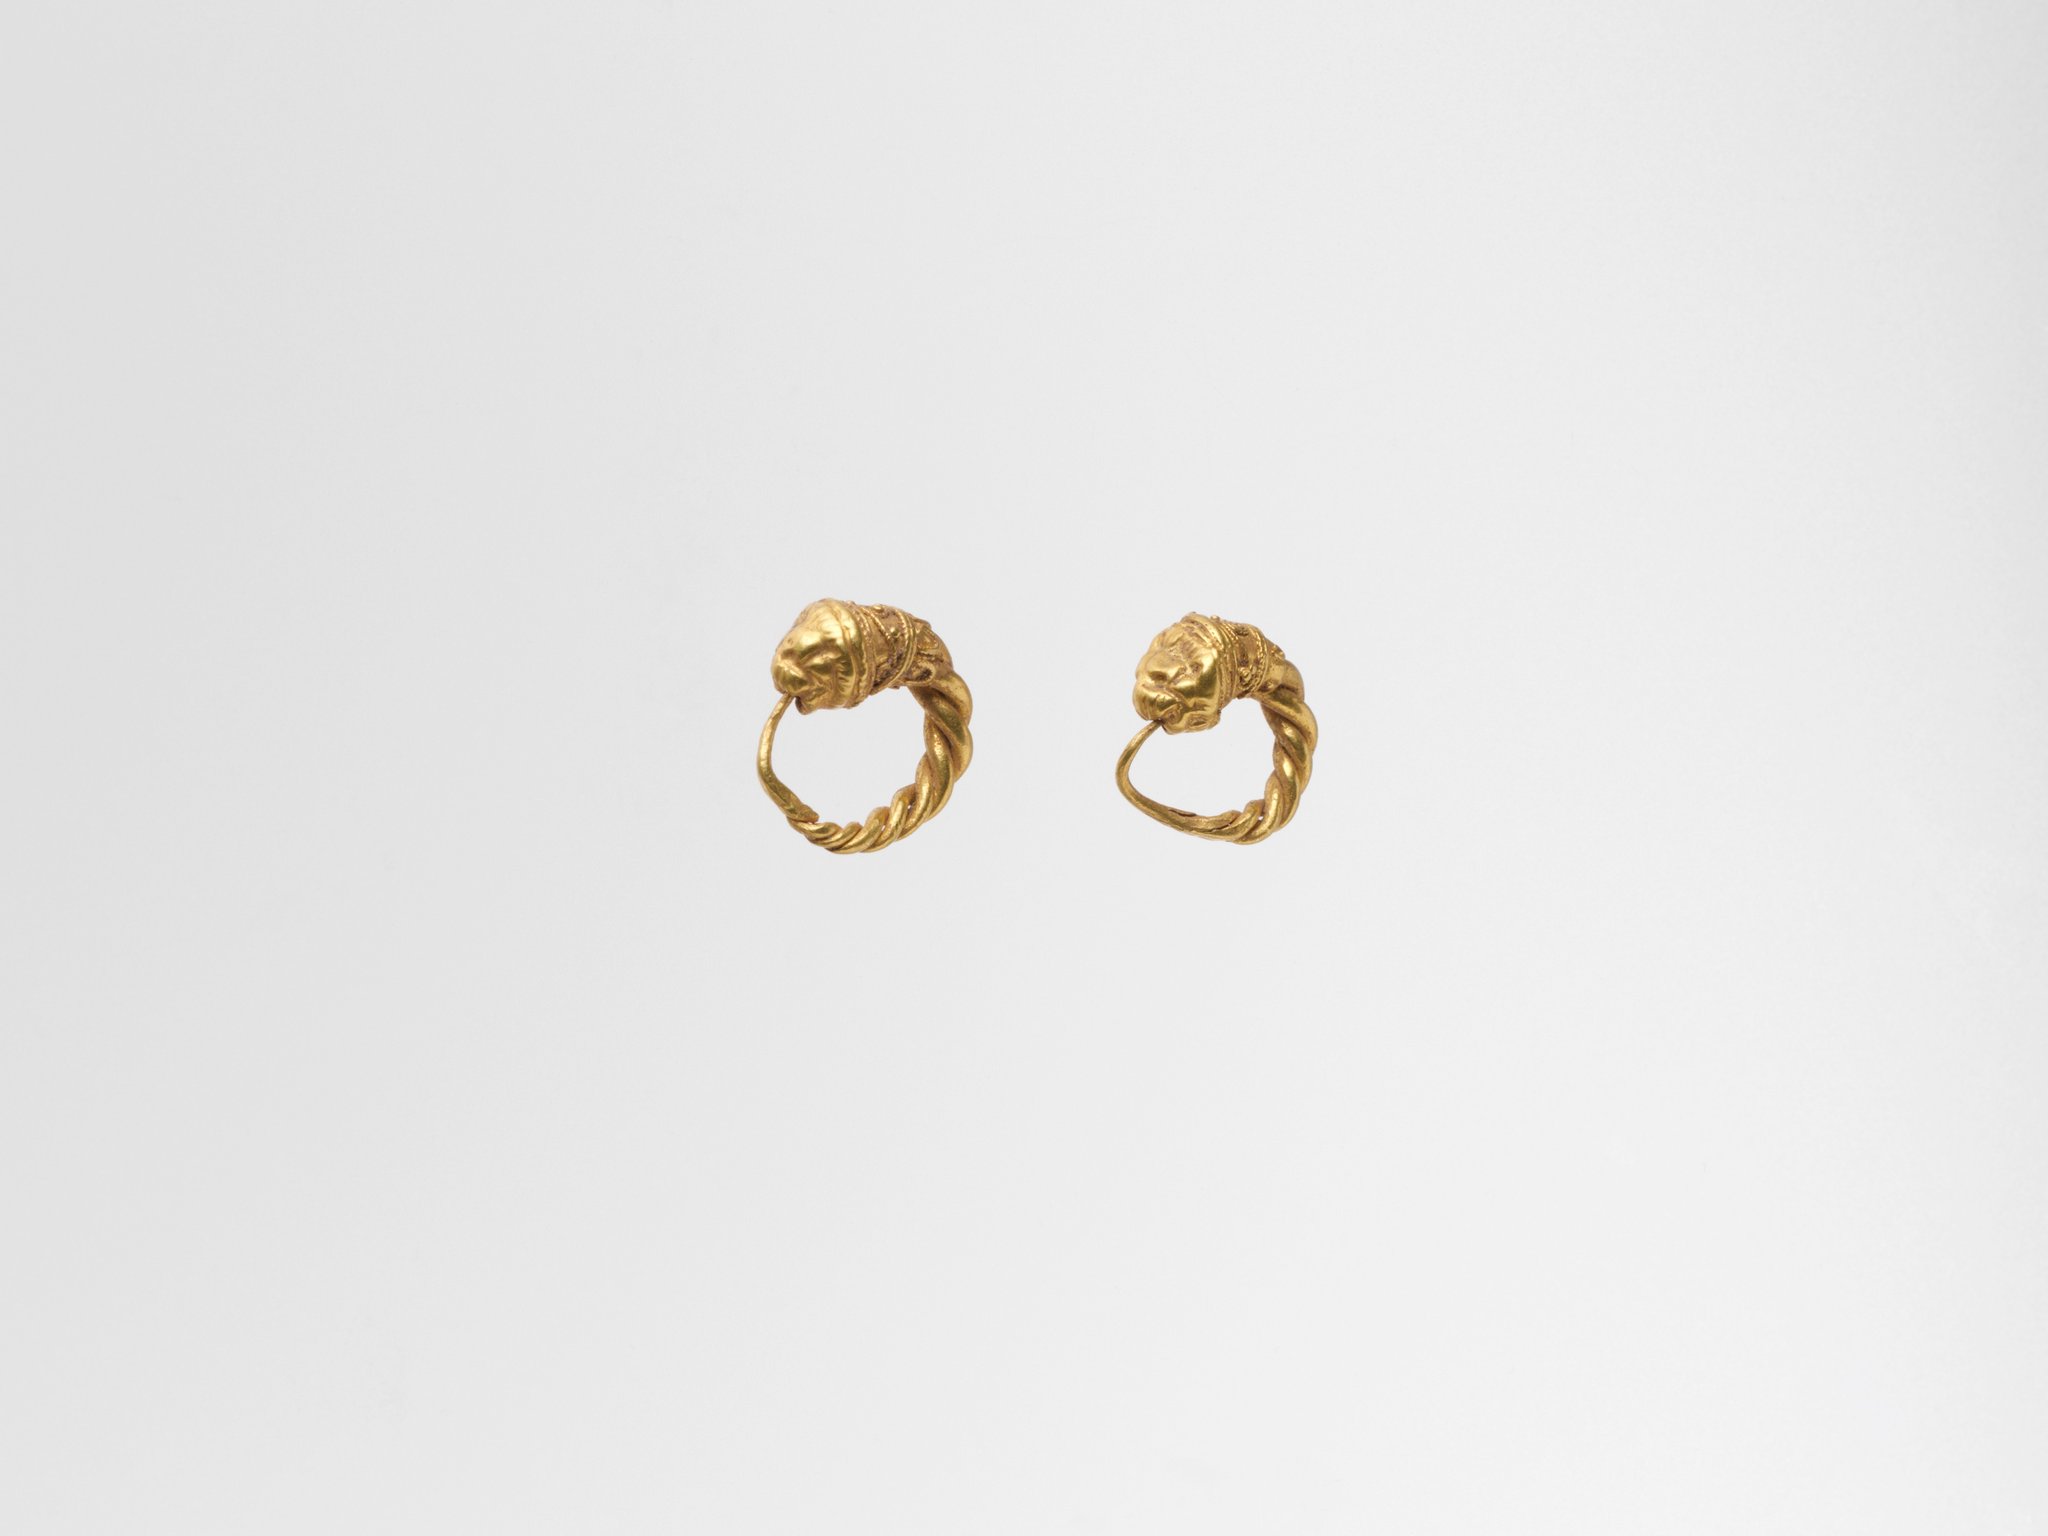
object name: earring with head of lion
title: Gold earring with head of a lion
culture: greek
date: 400-201 BCE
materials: gold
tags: lions